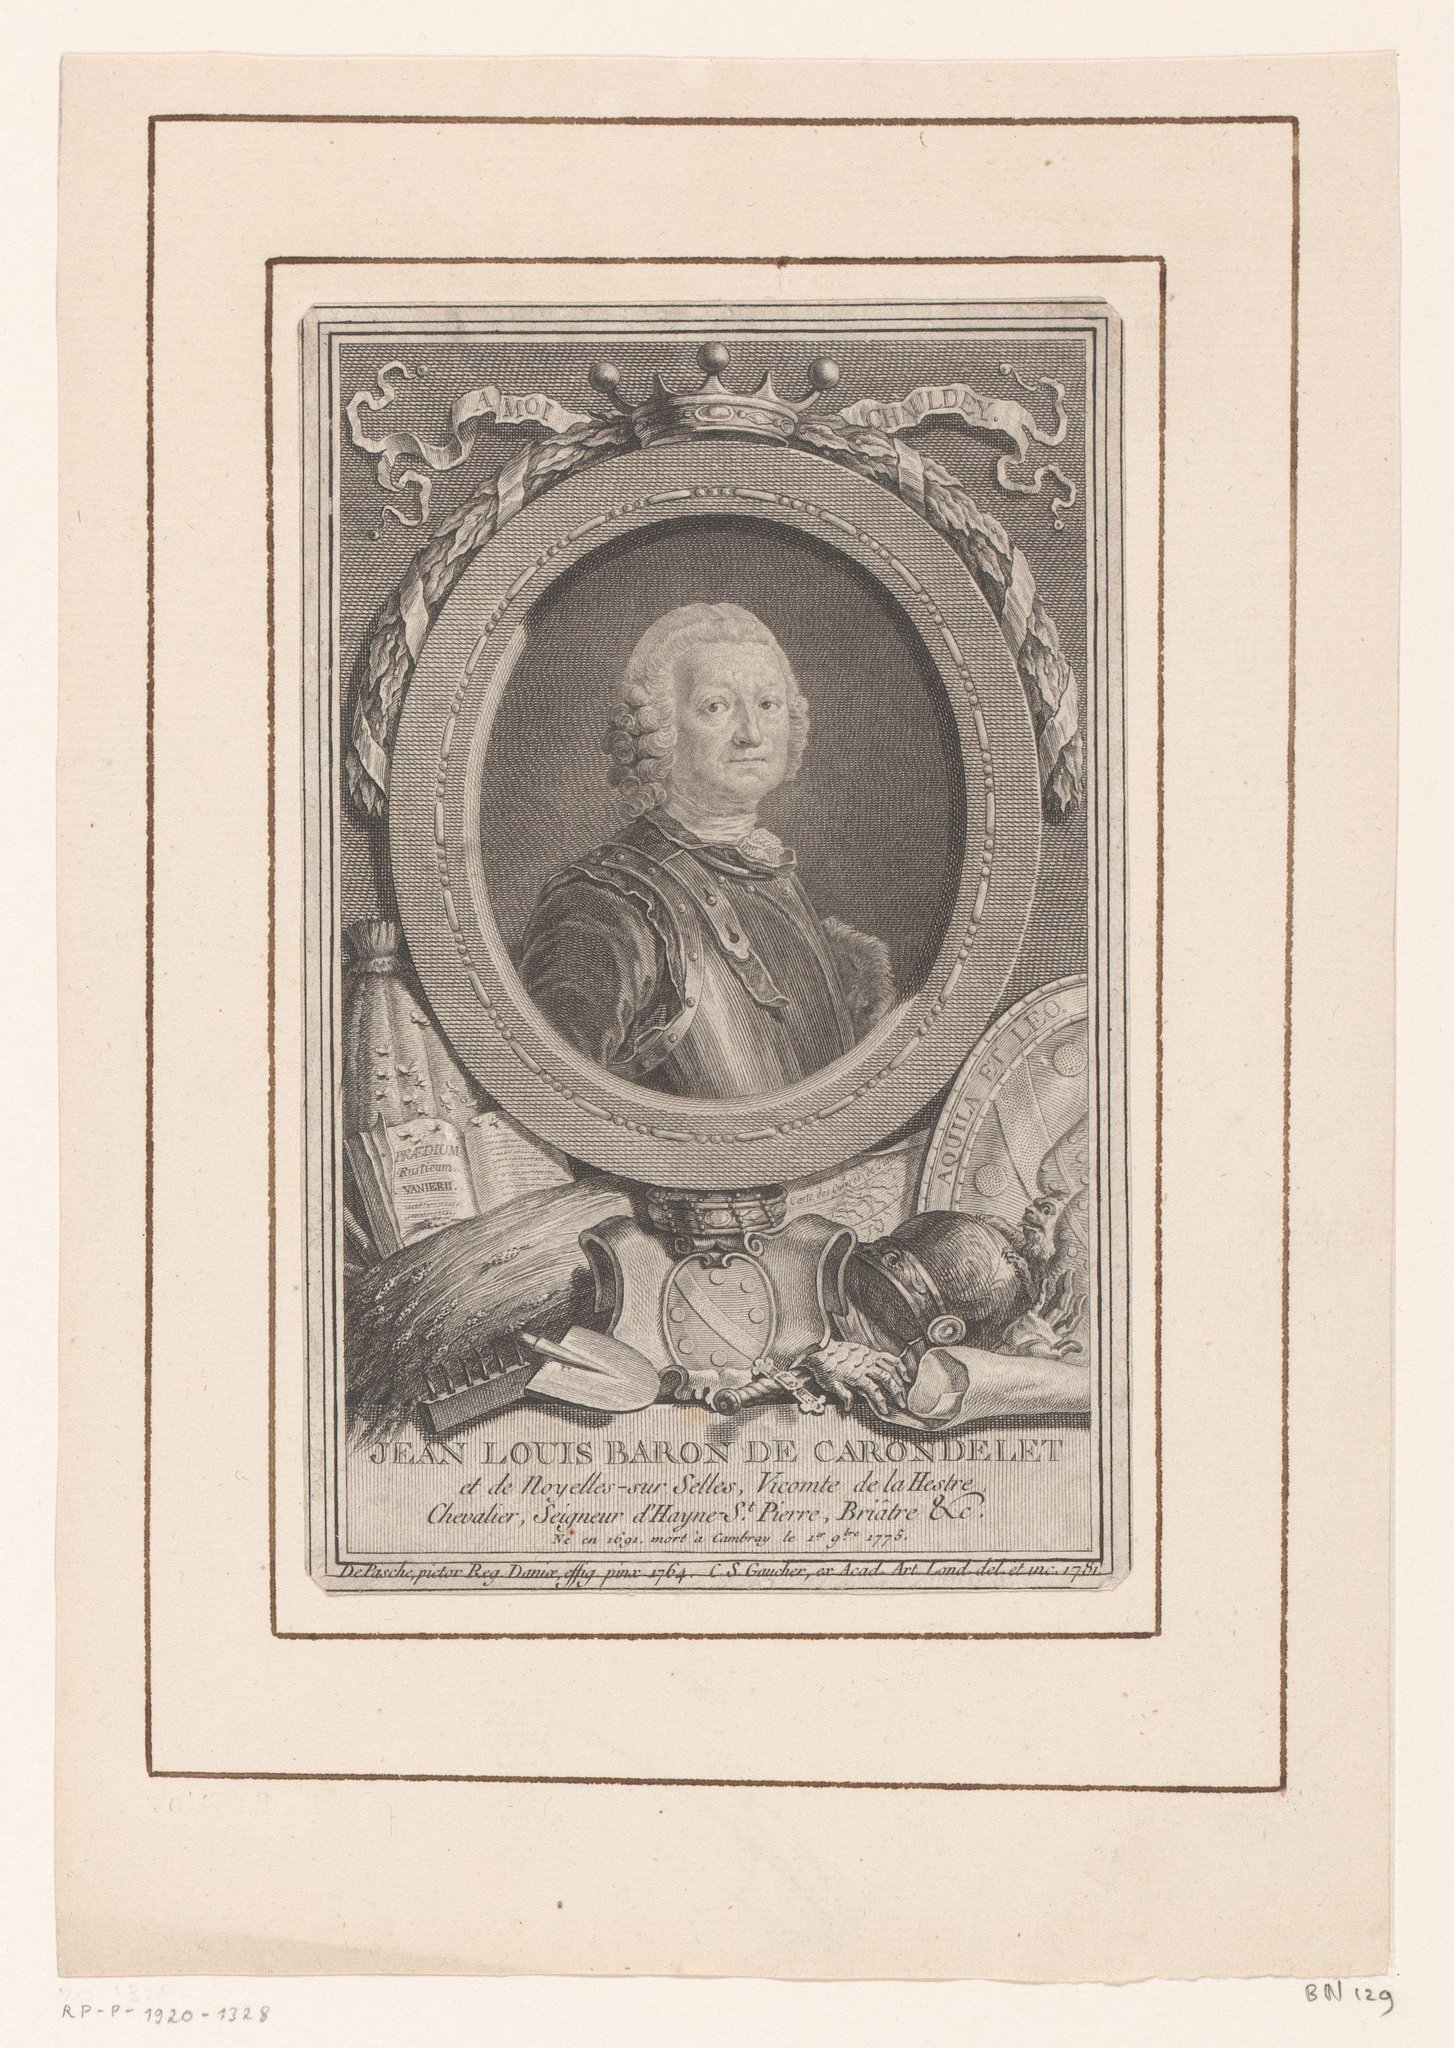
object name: print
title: Jean Louis baron de Carondelet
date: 1781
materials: paper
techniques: engraving, etching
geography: london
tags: helmet, ornament ~ medallion, historical persons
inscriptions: collector's mark: Lugt 2228